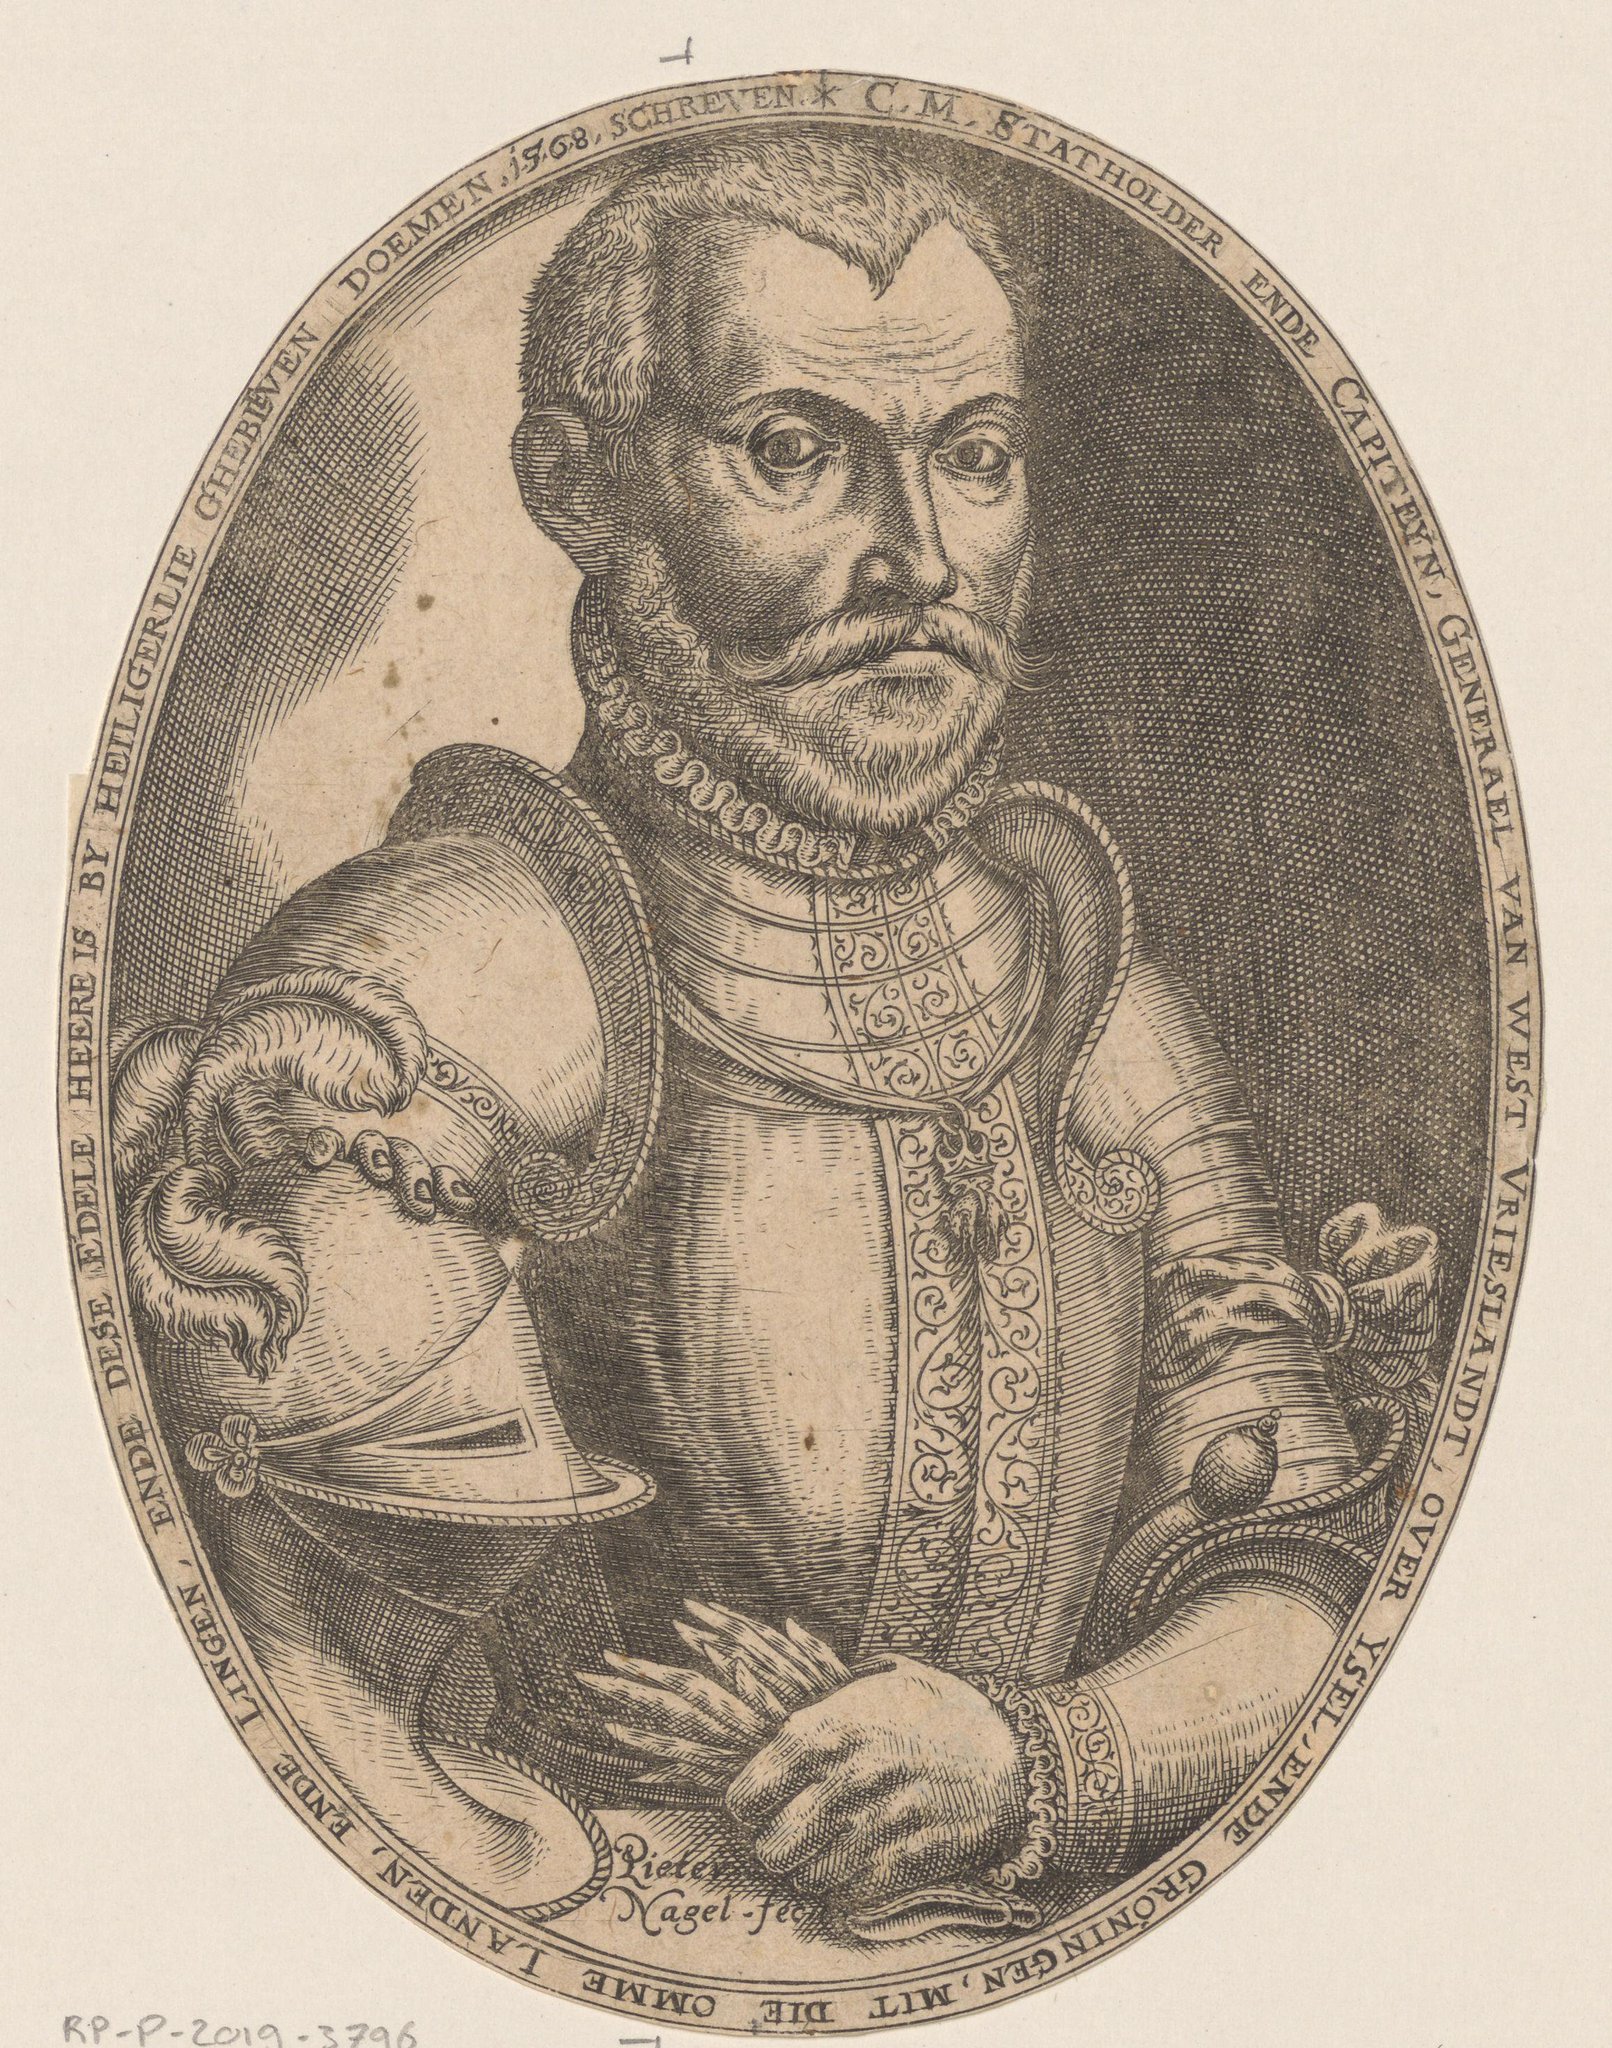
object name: print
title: Portret van Jean de Ligne, graaf van Arenberg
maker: pieter nagel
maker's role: print maker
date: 1569-1604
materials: paper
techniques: engraving, etching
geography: antwerp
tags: jean de ligne (duke of arenberg), armour, historical persons, knighthood order of the golden fleece - insignia of a knighthood order, e.g.: badge, chain (with name of order)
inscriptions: collector's mark: Lugt 964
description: Met om zijn nek de keten van de Orde van het Gulden Vlies.